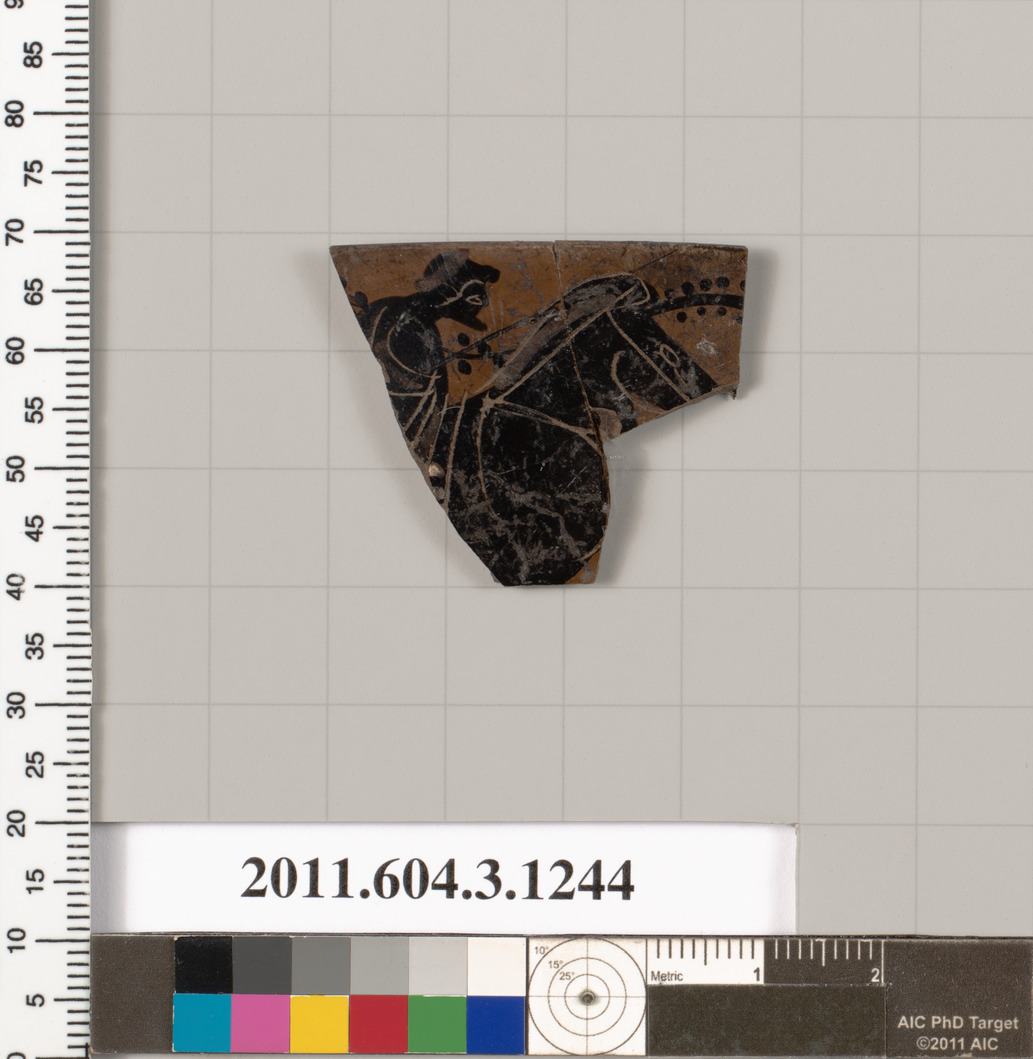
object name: kyathos fragment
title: Terracotta rim fragment of a kyathos (cup-shaped ladle)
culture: greek, attic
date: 534-468 BCE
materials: terracotta